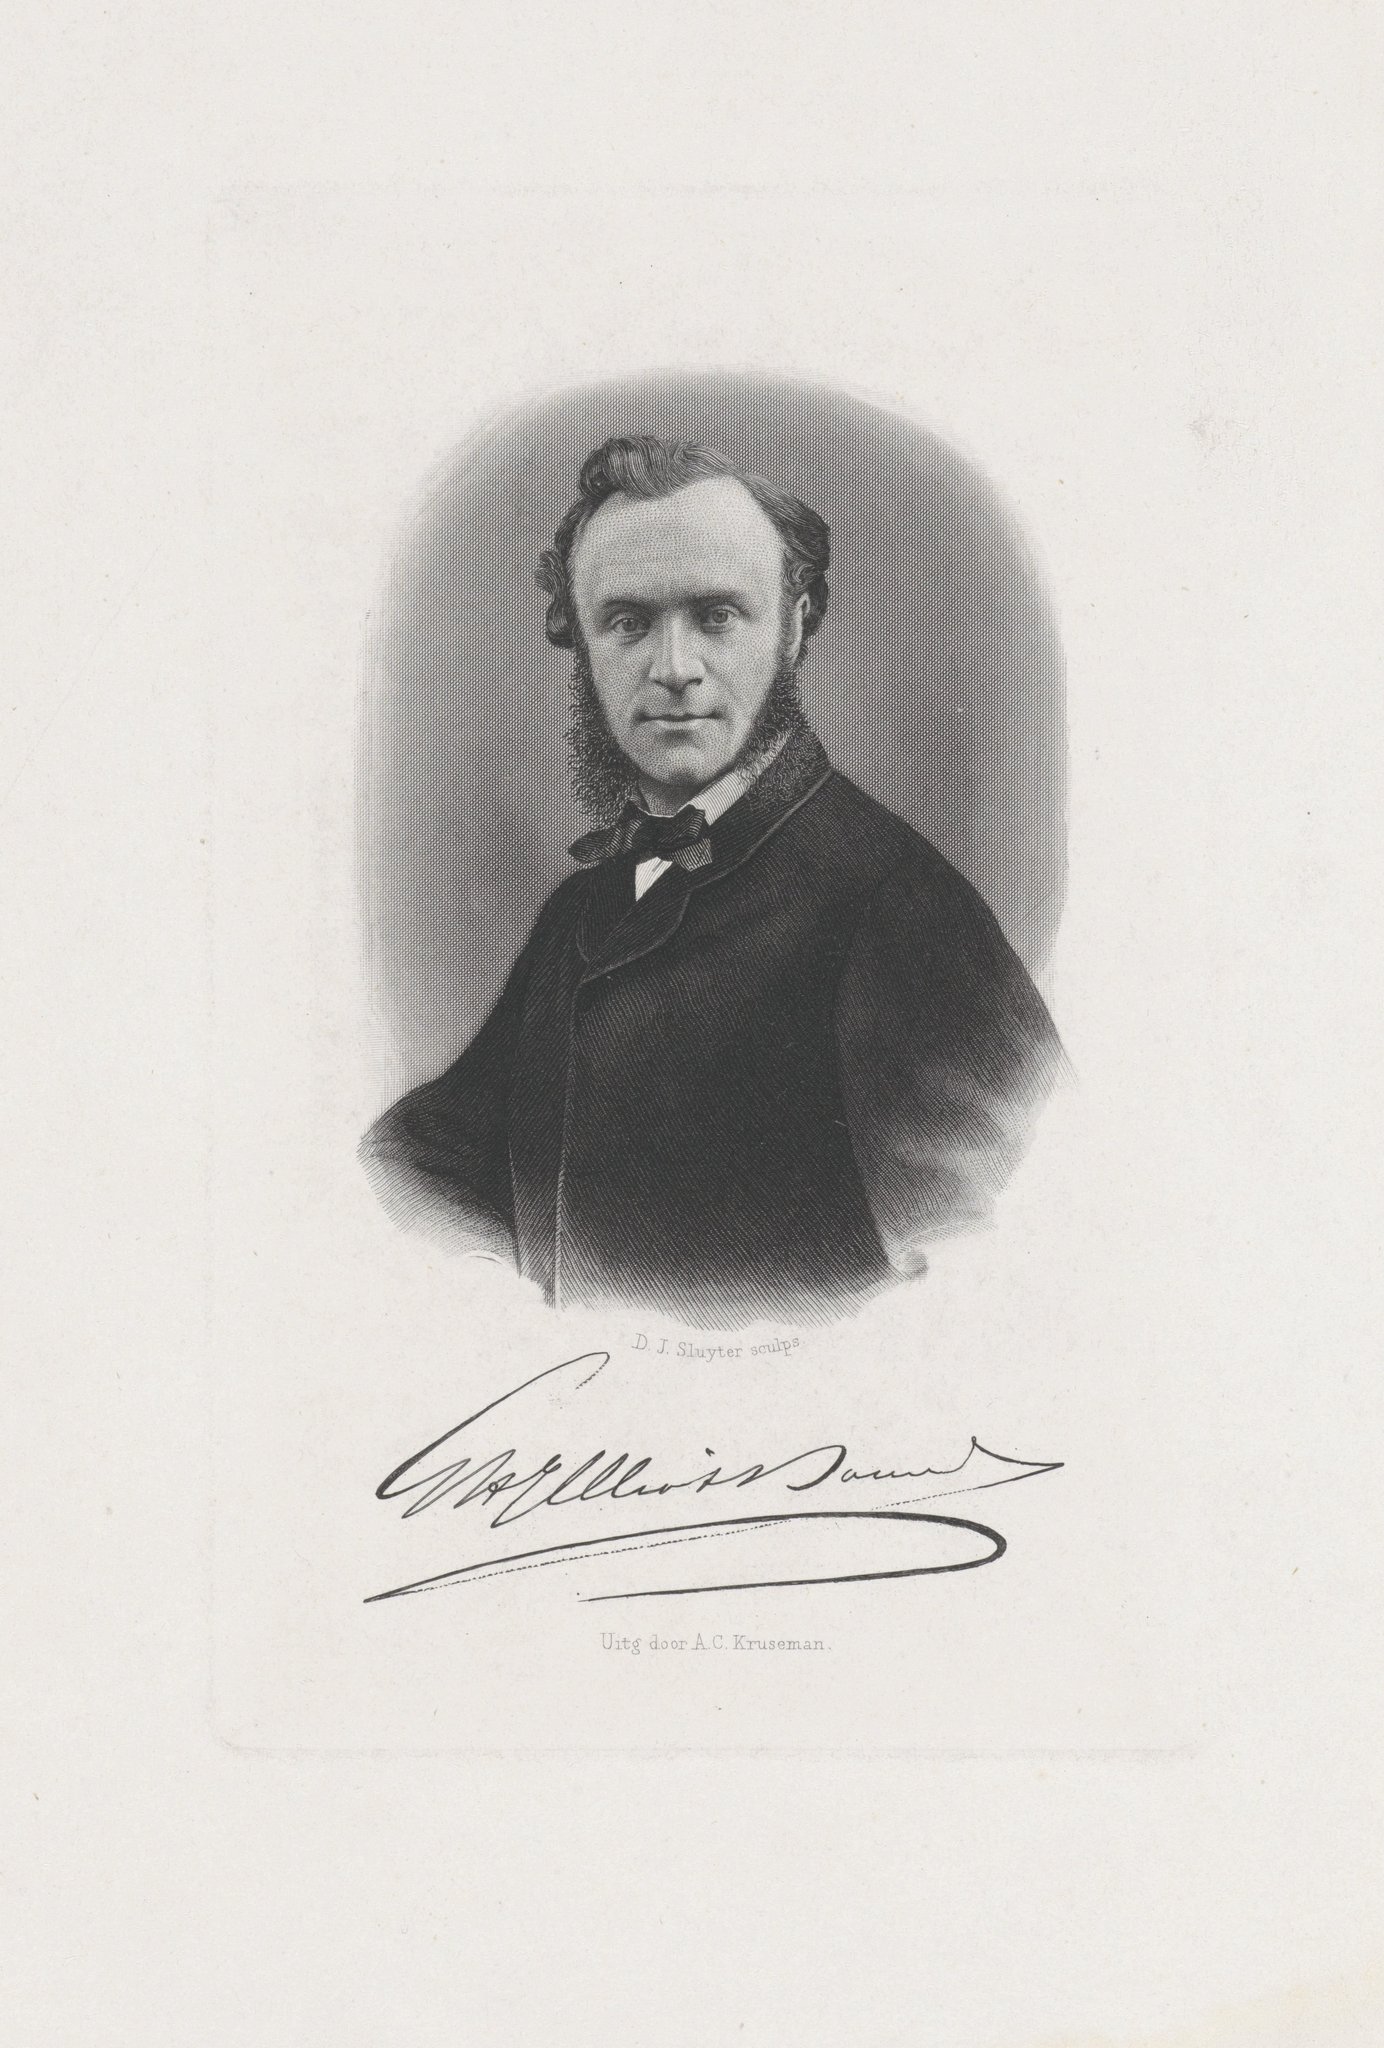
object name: print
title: Portret van George Henry James Elliot Boswel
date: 1850-1873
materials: paper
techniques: etching, engraving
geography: amsterdam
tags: portrait of a writer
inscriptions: collector's mark: Lugt 2228